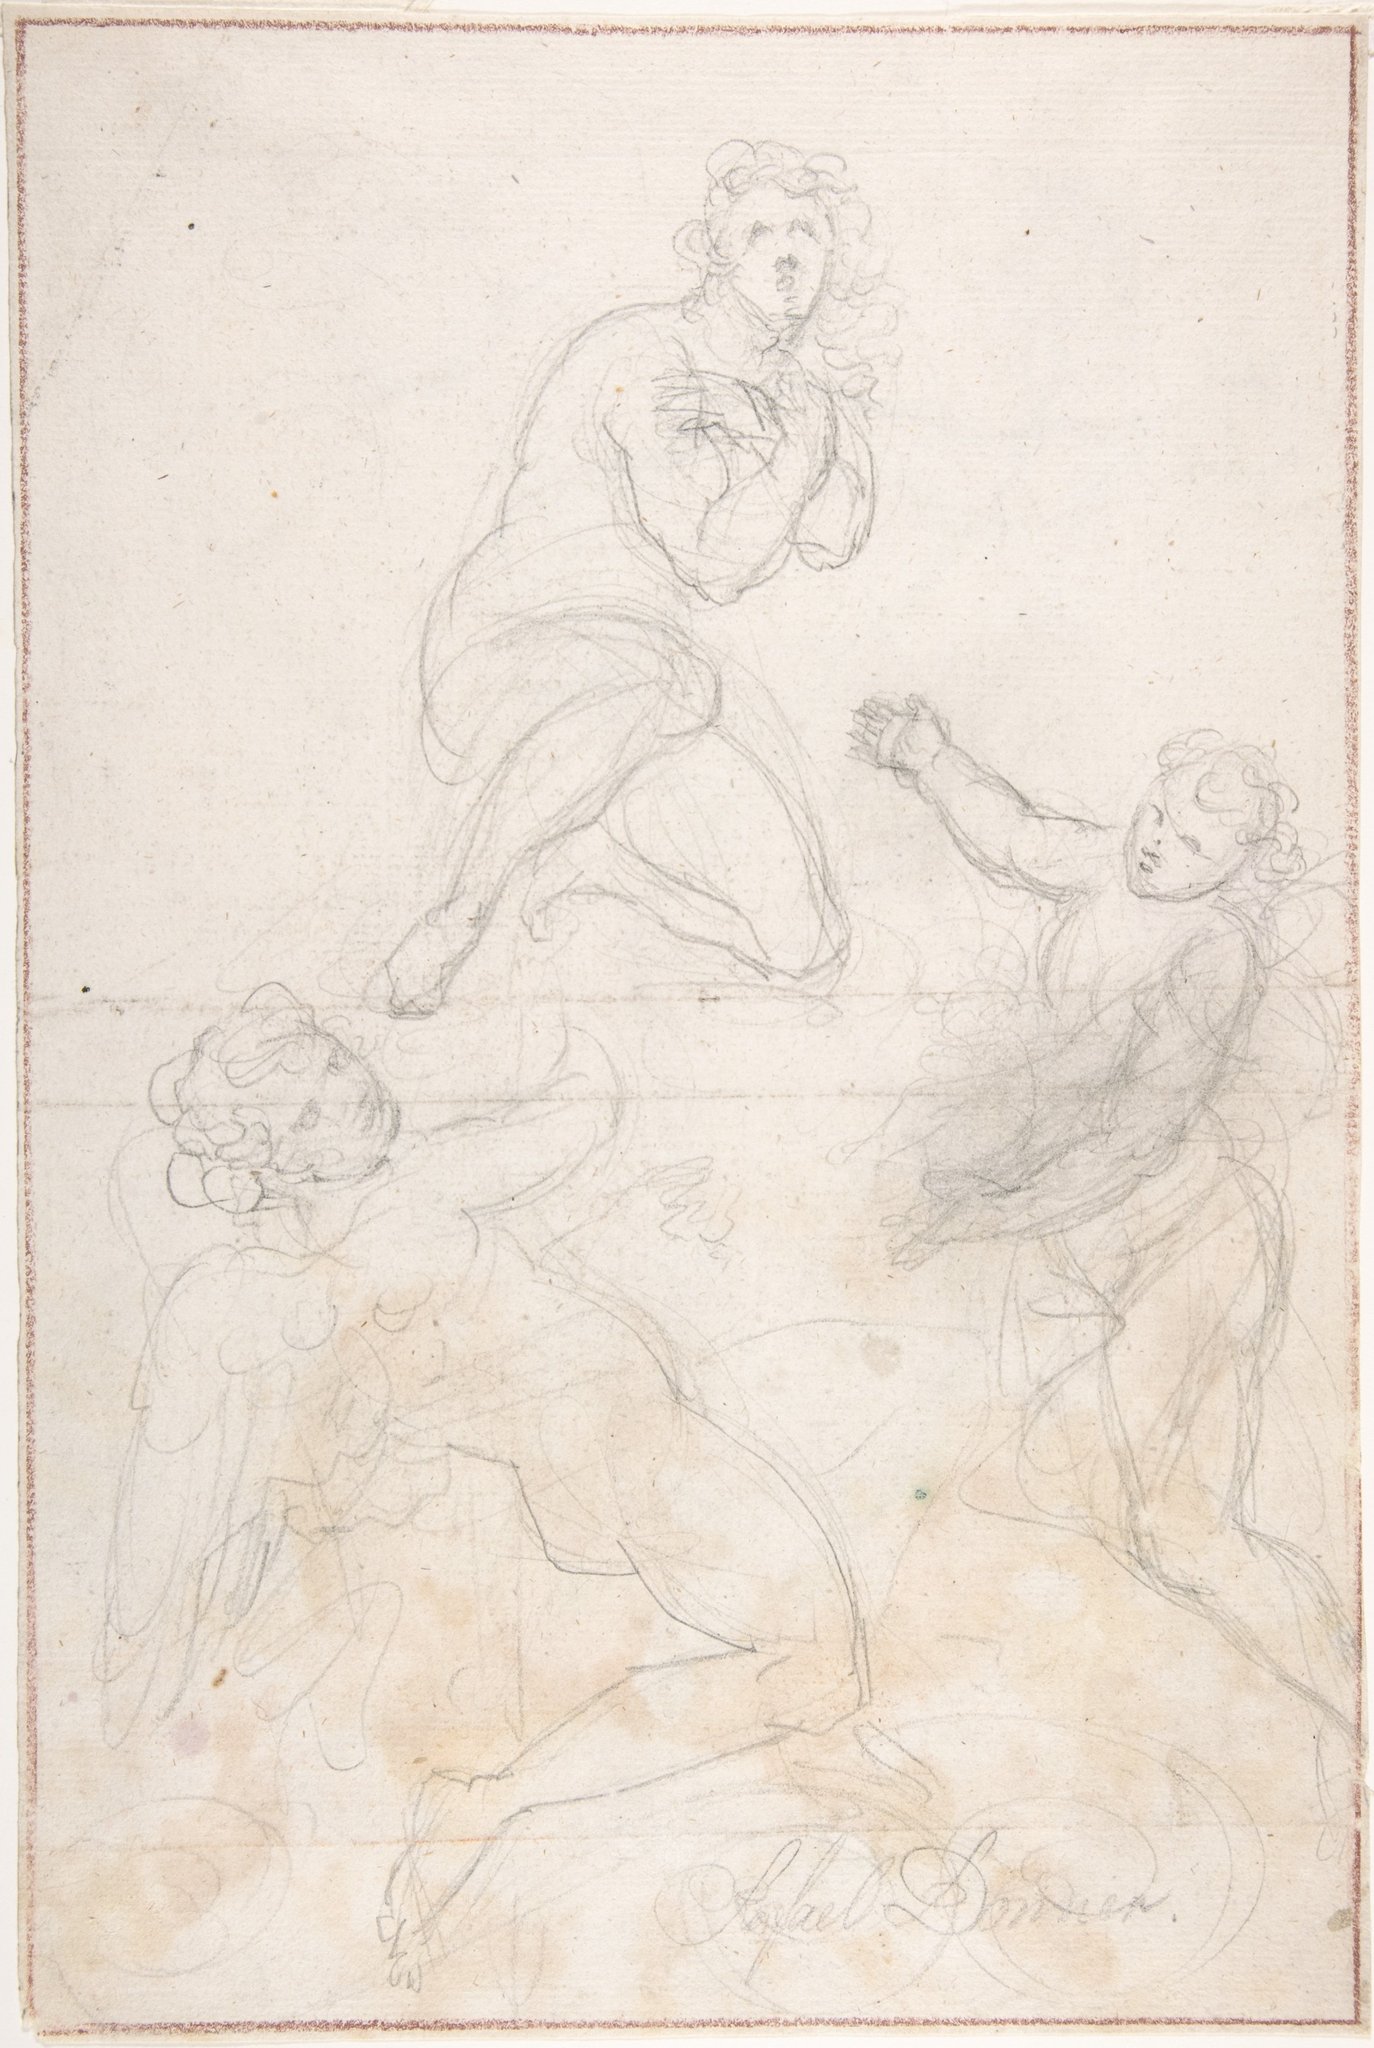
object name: drawing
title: Kneeling Female Nude and Two Studies of Angels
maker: georg raphael donner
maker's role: artist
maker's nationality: austrian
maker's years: 1693-1741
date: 1701-1733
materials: chalk, paper, pencil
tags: female nudes,angels